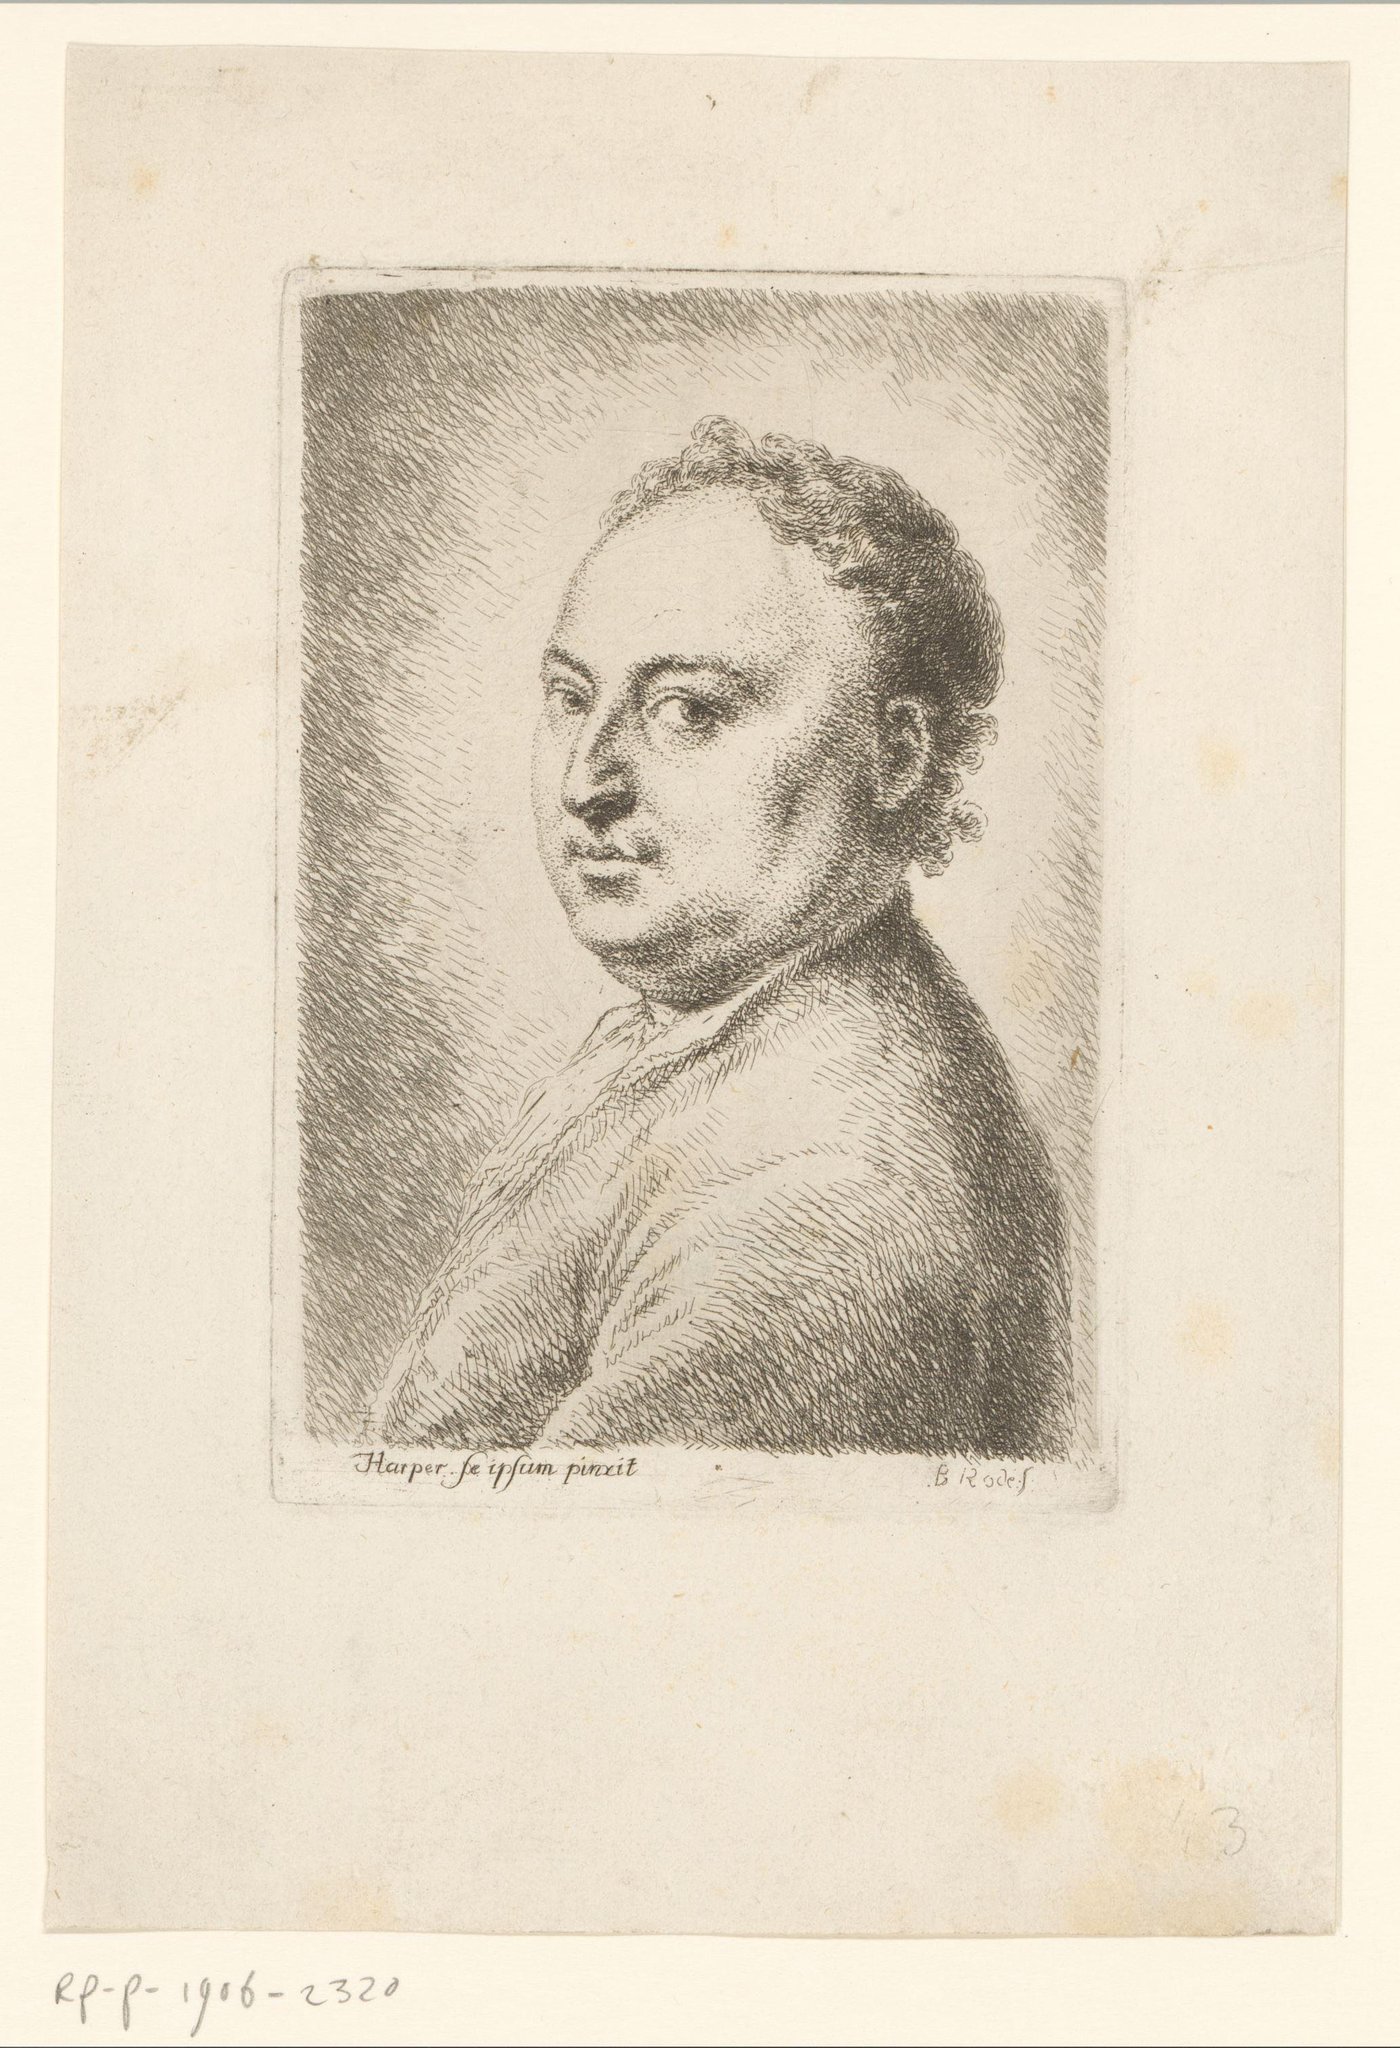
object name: print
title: Portret van een onbekende man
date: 1735-1797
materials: paper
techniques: etching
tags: adult man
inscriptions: collector's mark: Lugt 2228